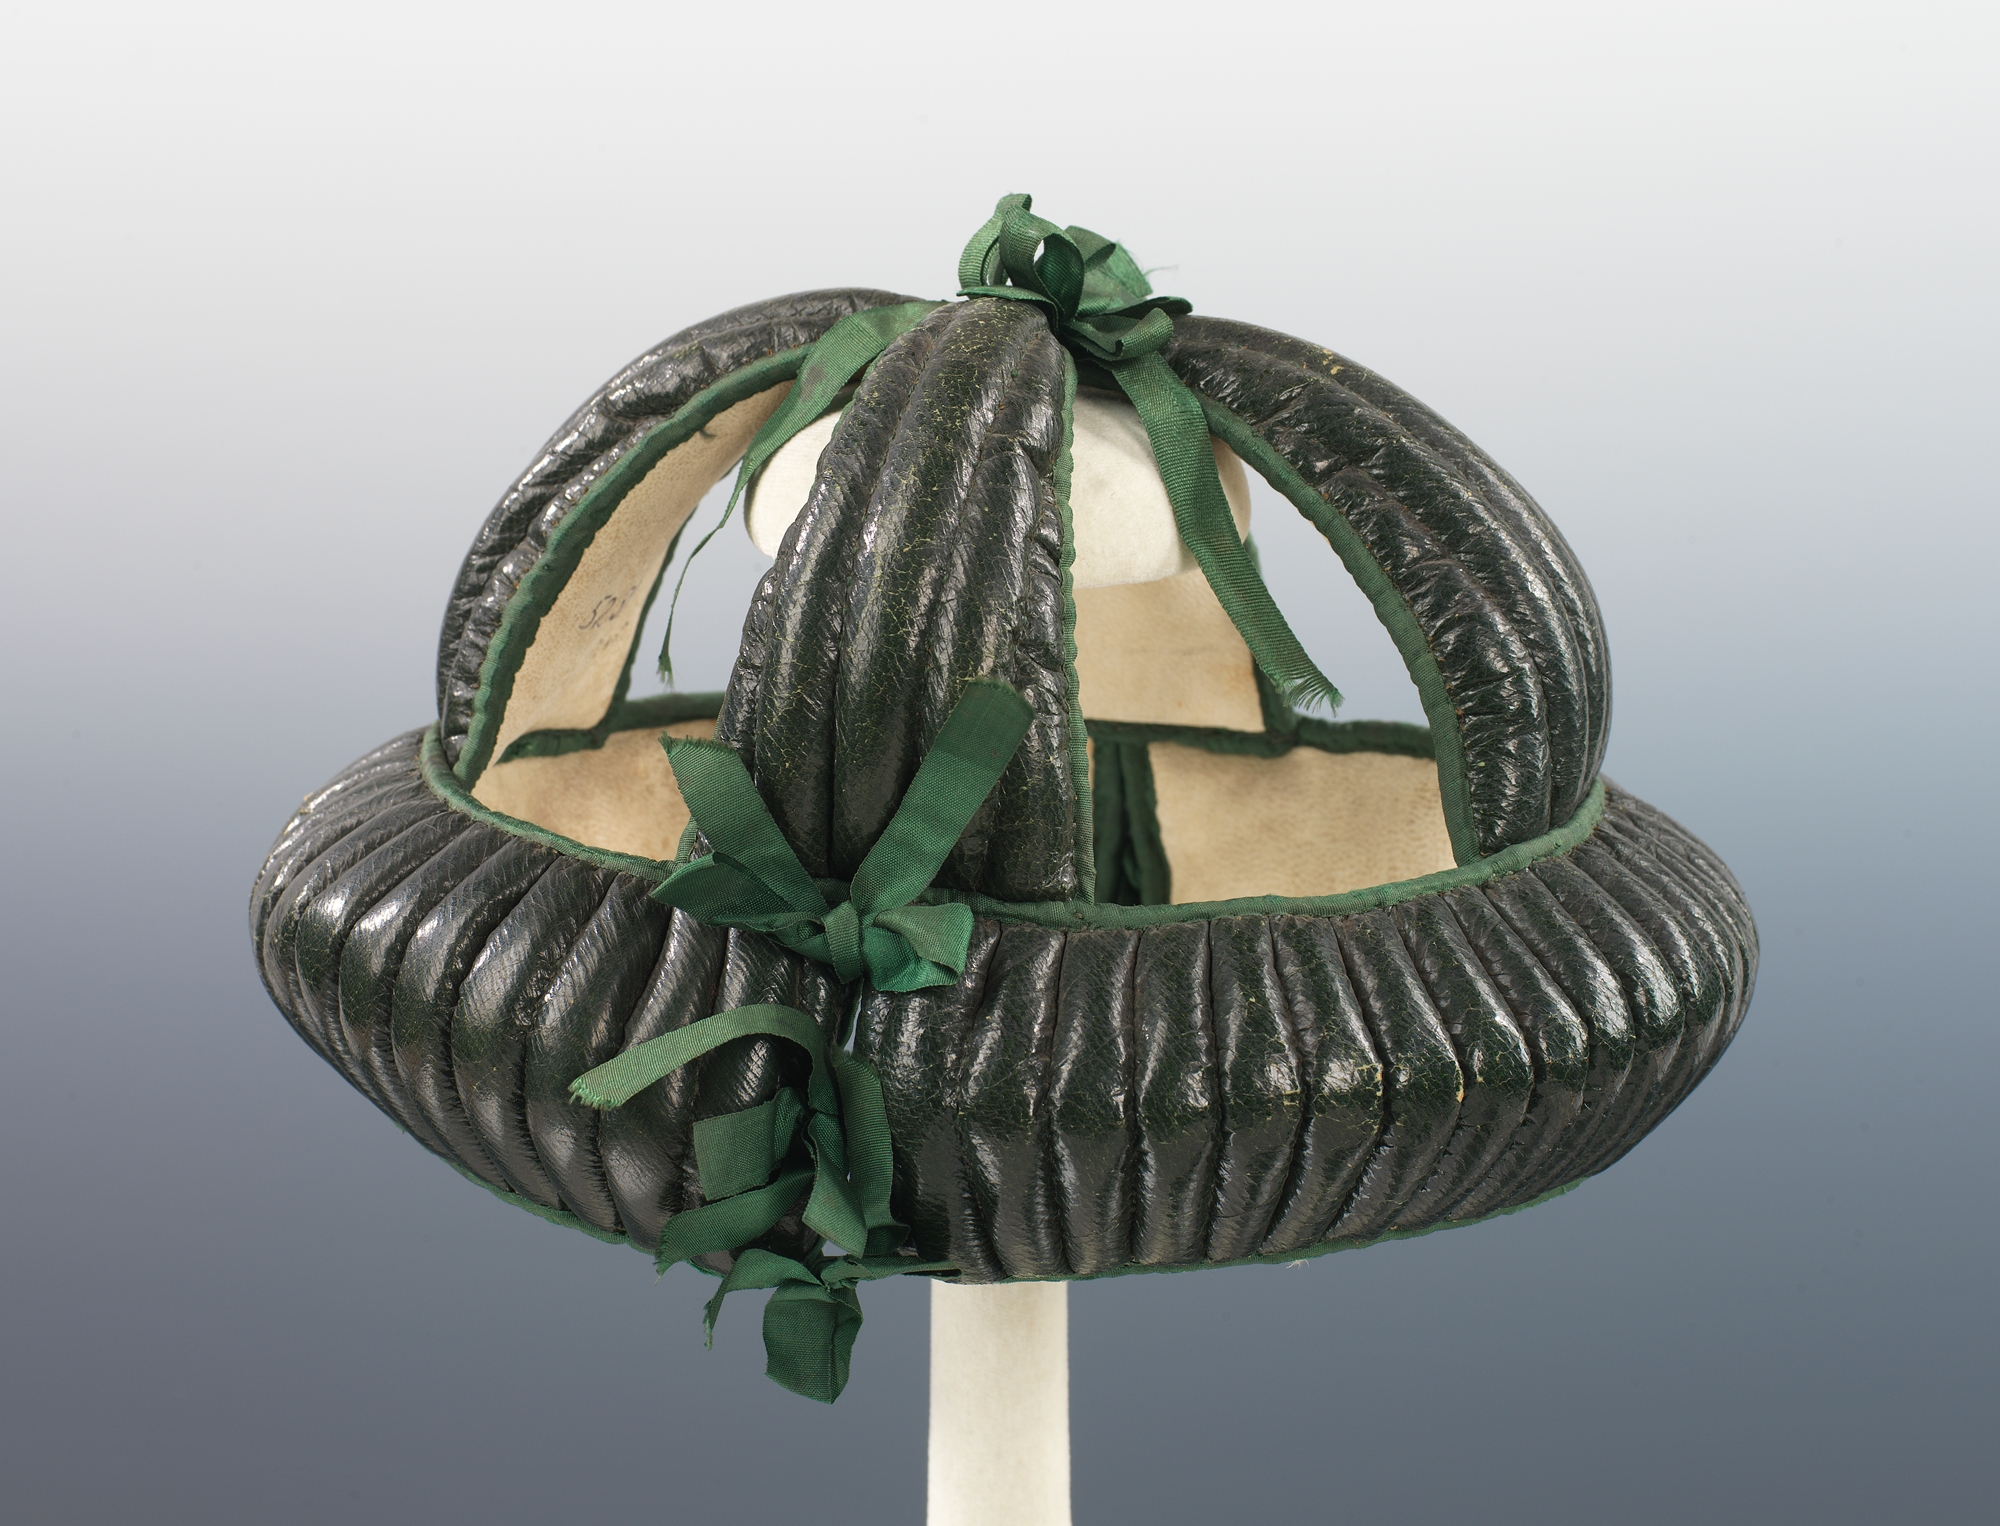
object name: cap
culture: american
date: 1801-1825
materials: leather, silk